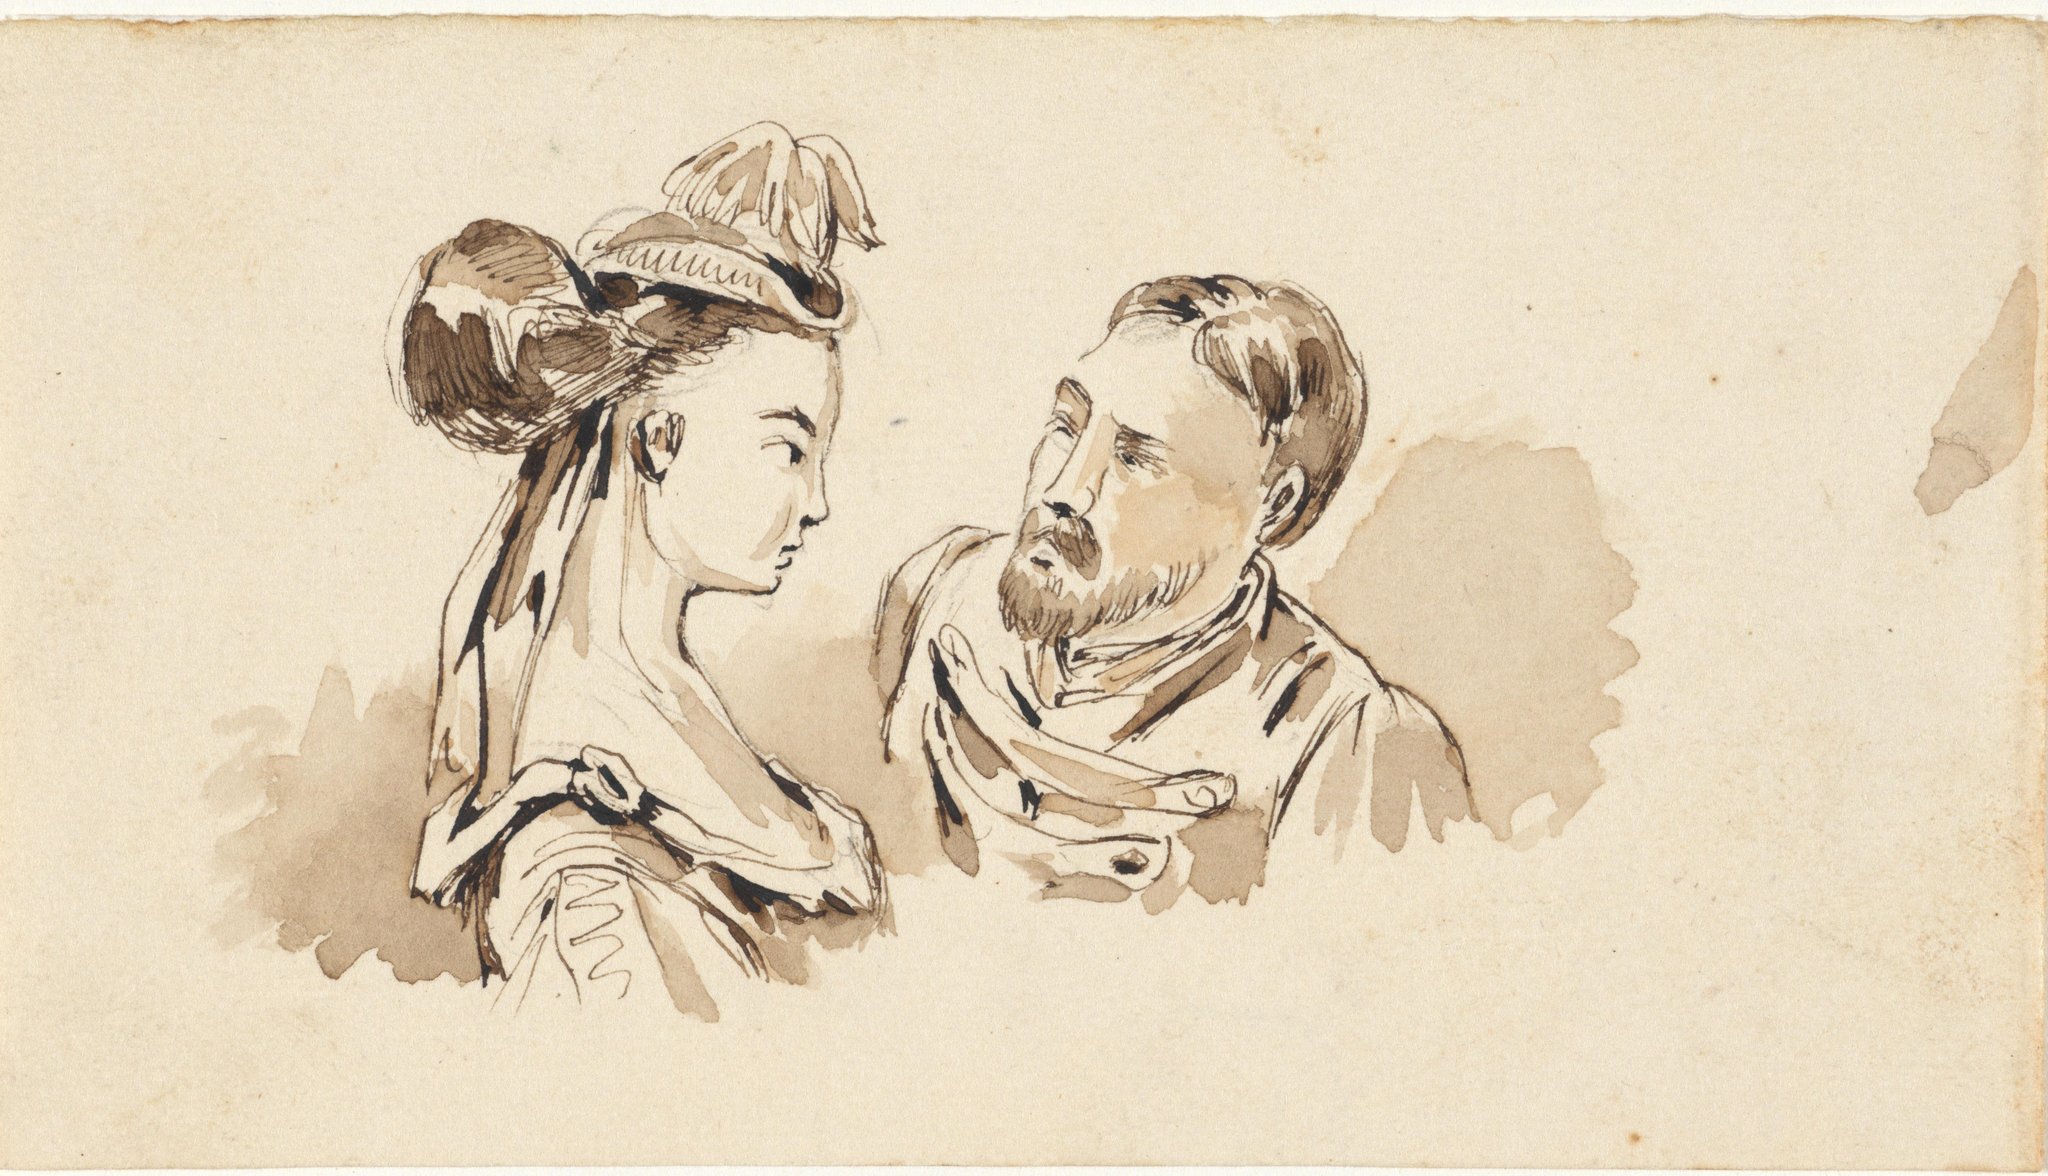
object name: drawing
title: Borstbeelden van een man en een vrouw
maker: pieter van loon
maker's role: draughtsman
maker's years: 1801-1873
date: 1811-1873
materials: paper, pencil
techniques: brush, pen